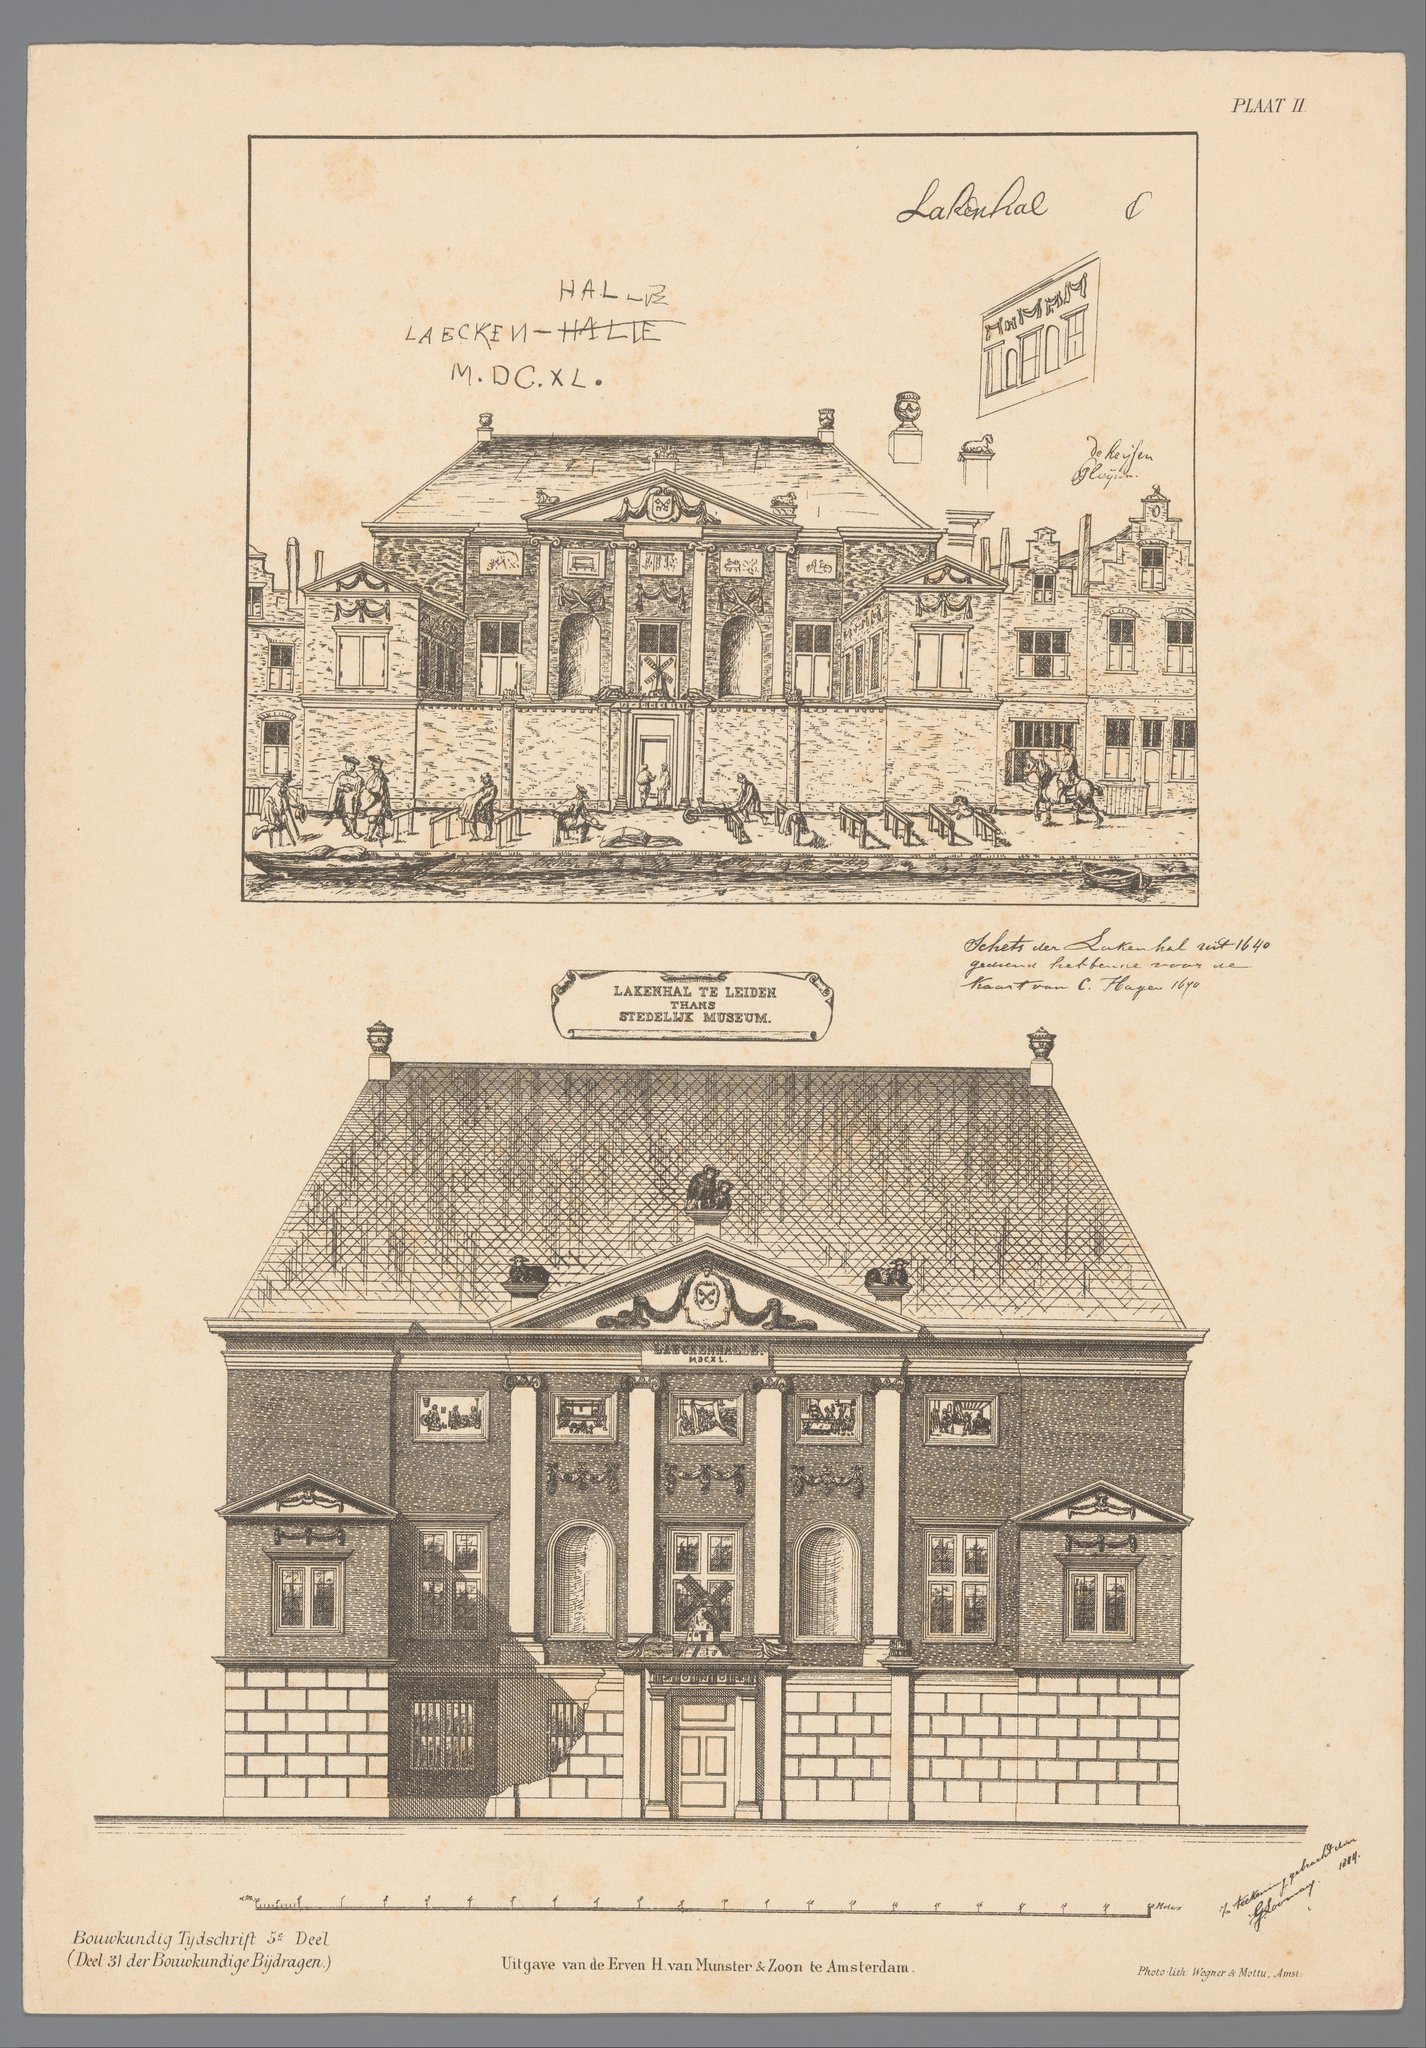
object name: photomechanical print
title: Lakenhal te Leiden thans Stedelijk Museum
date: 1885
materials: paper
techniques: photolithography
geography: amsterdam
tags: permanent exhibition, museum, civic architecture; edifices; dwellings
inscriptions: signature: ‘GL[...]’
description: Rechtsboven: plaat II. Linksonder: Bouwkundig Tijdschrift 5e Deel (Deel 31 der Bouwkundige Bijdragen).